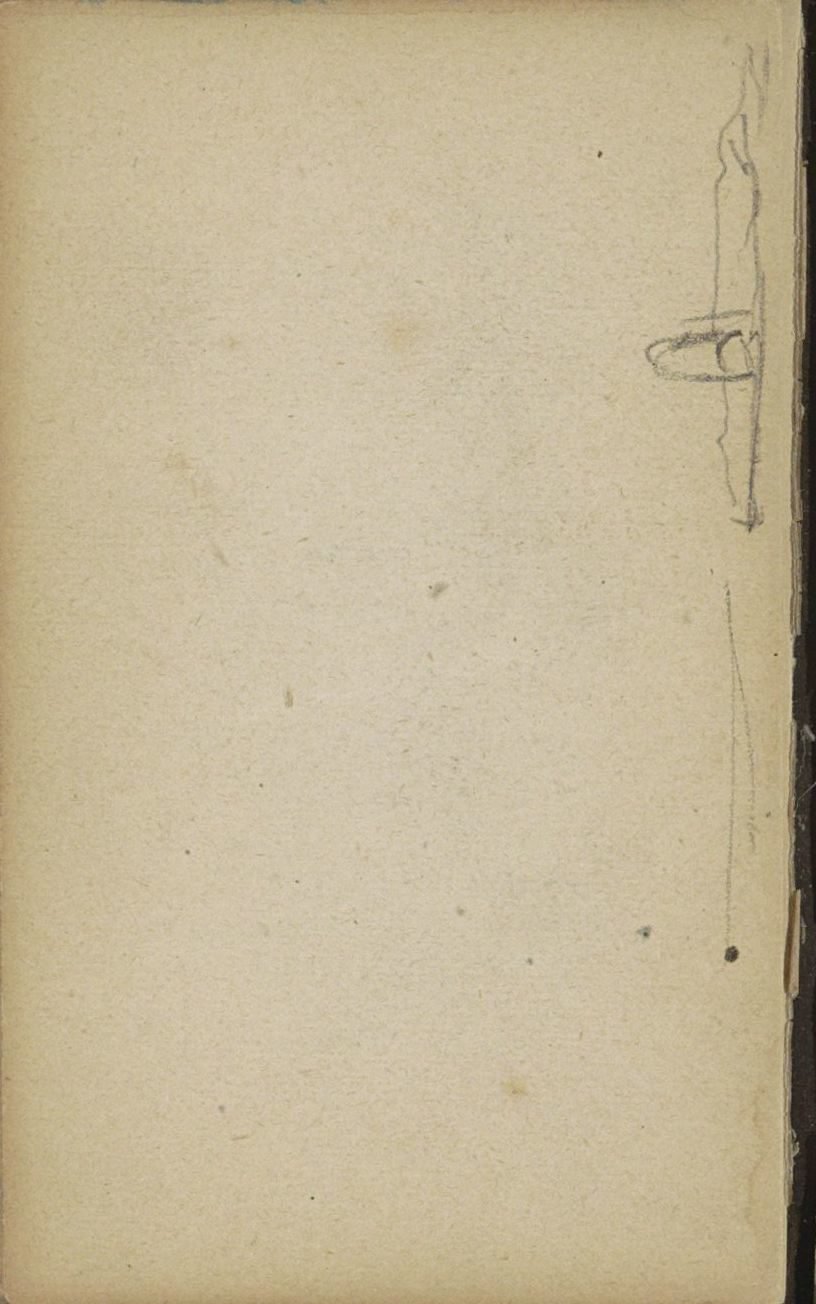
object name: sketchbook leaf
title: Studie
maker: johan hendrik weissenbruch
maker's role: draughtsman, painter, print maker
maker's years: 1824-1903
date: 1834-1903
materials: paper, pencil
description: Blad 31 verso uit een schetsboek met 32 bladen.